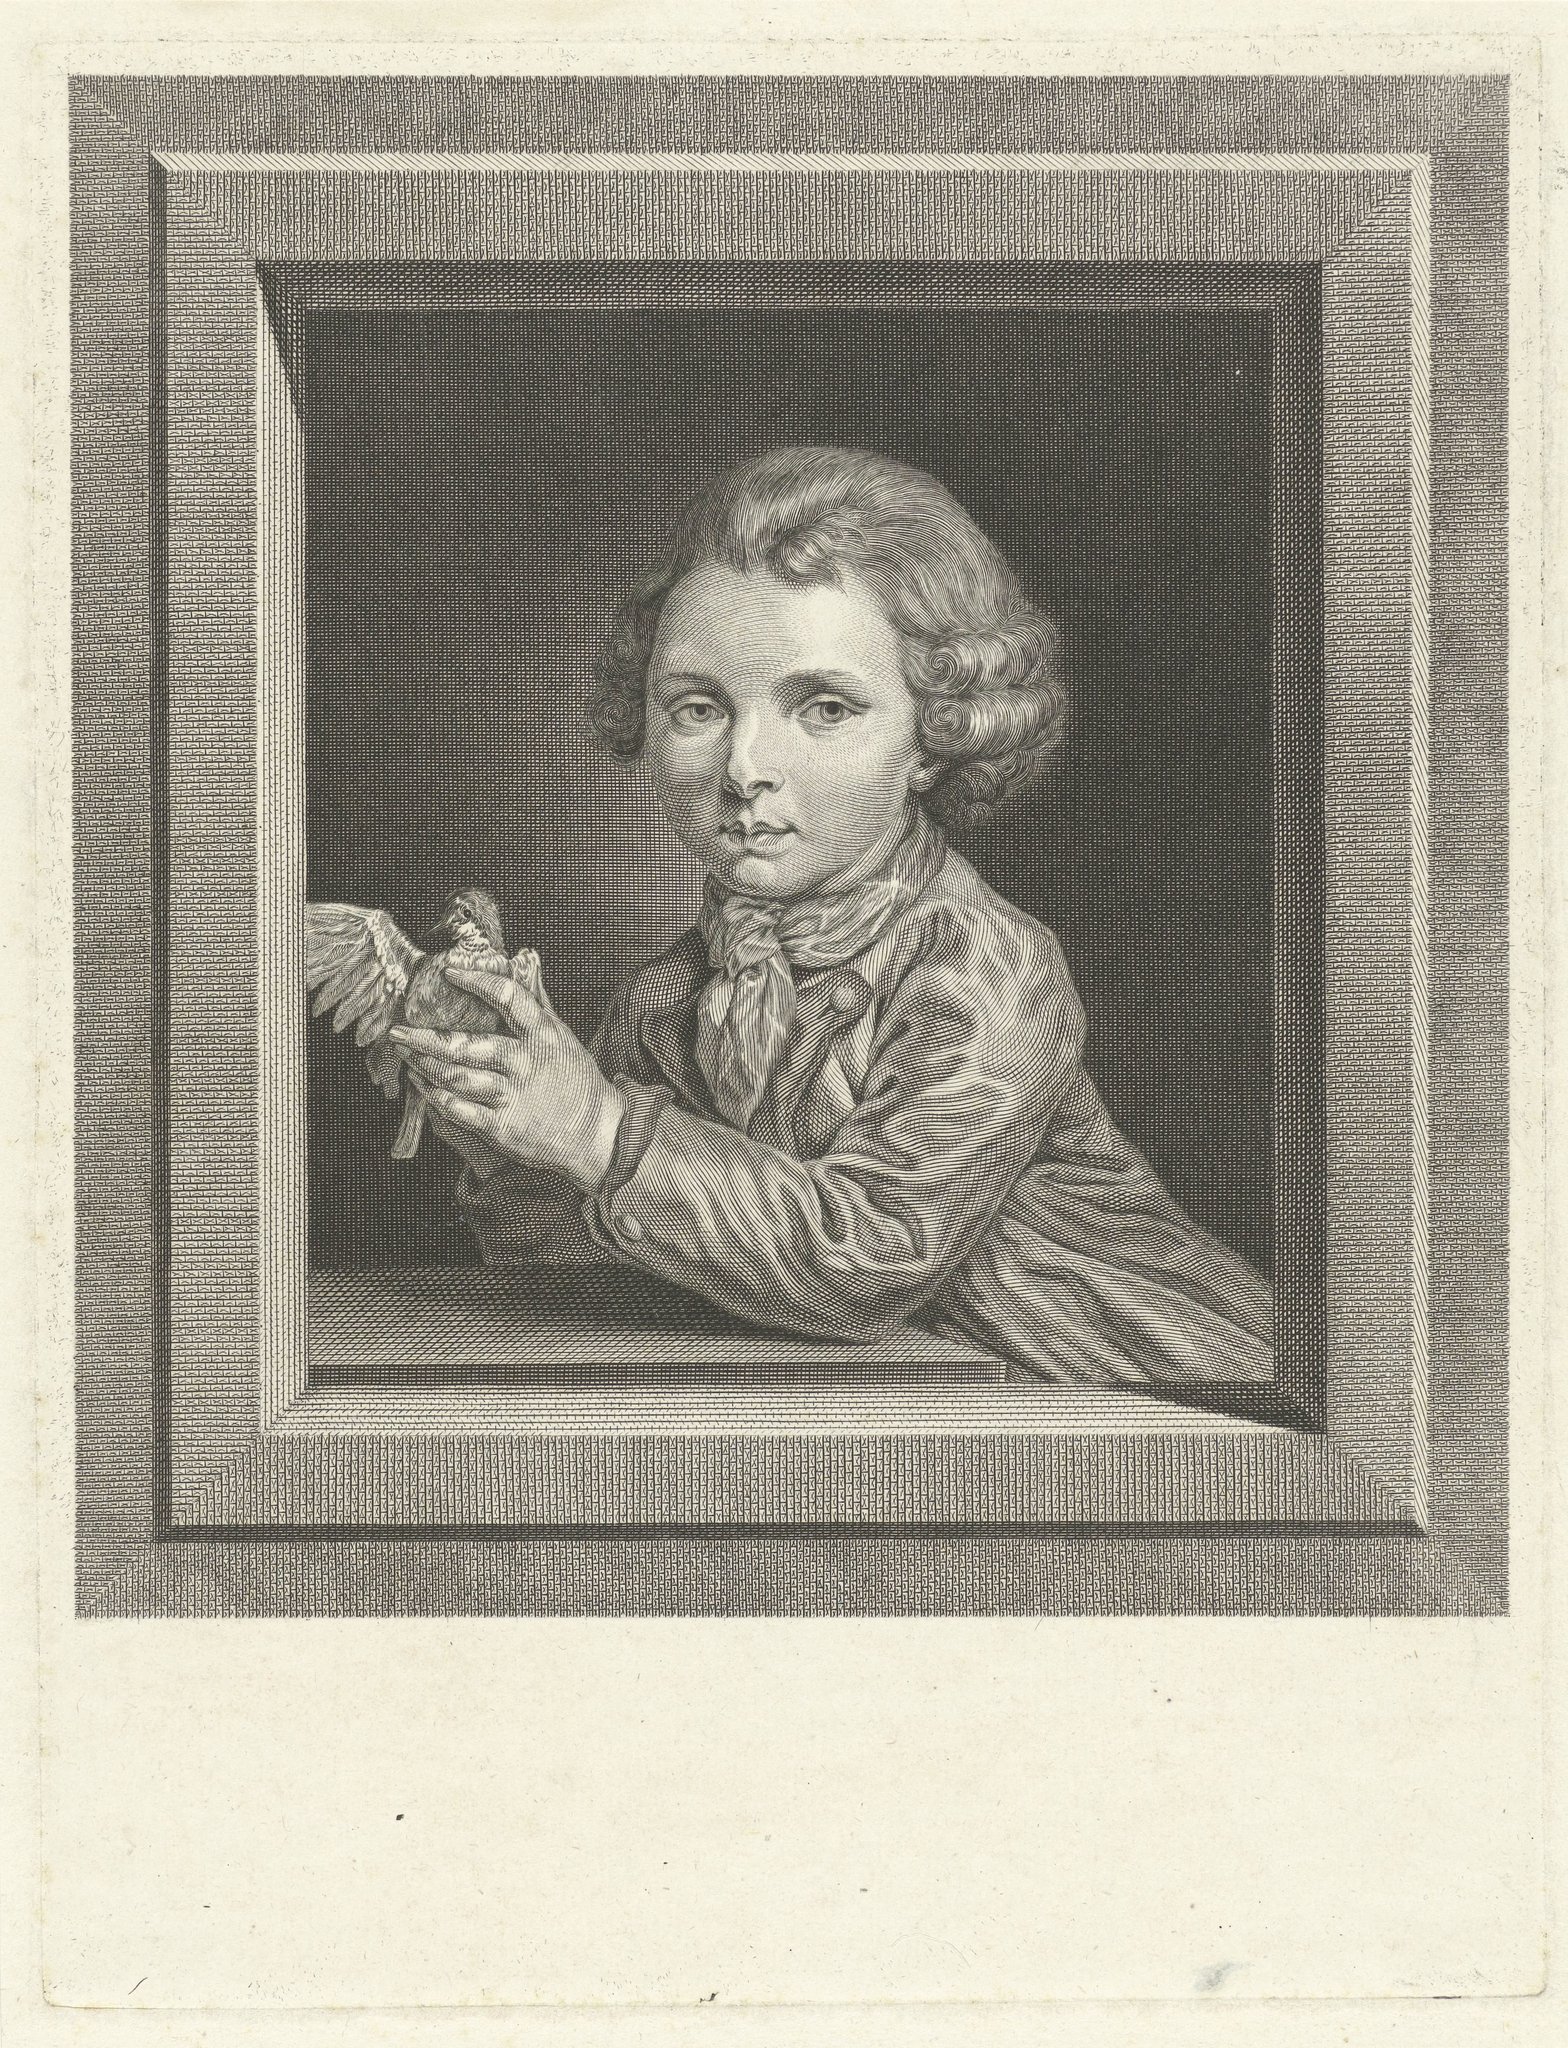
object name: print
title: Kleine vogelvanger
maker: pieter willem van megen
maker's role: print maker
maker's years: 1750-1785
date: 1760-1785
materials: paper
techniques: engraving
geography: the hague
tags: birds, boy (child between toddler and youth)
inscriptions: collector's mark: Lugt 240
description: Portret van een onbekende jongen als de kleine vogelvanger met een vogel in zijn handen.